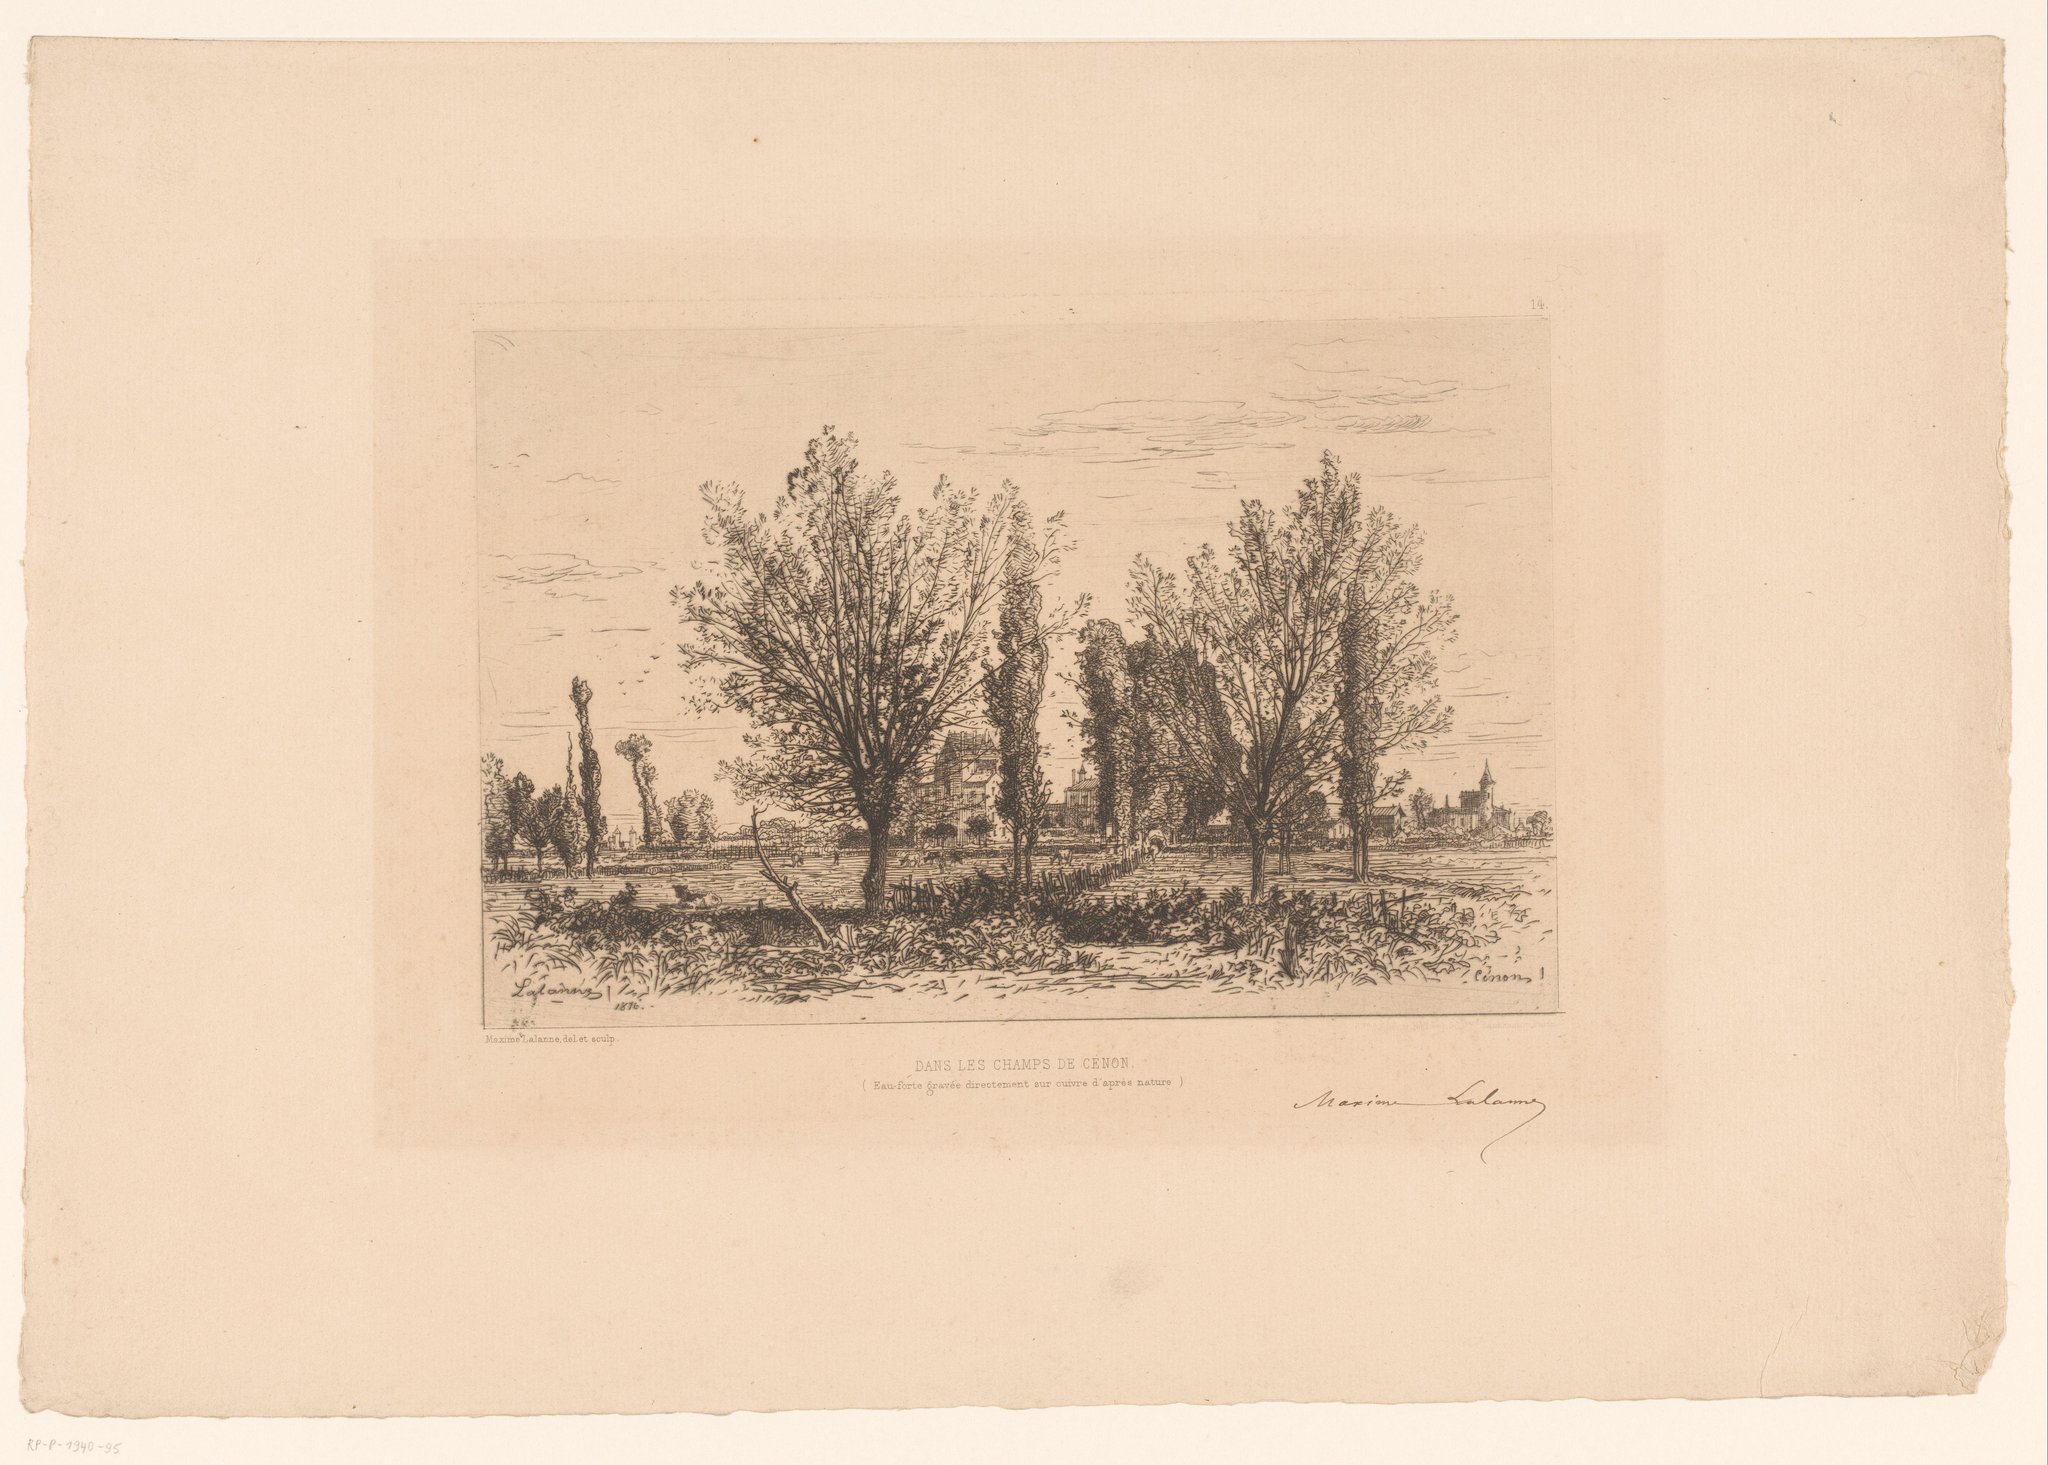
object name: print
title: Landschap met weide en zicht op een stad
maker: maxime françois antoine lalanne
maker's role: draughtsman, print maker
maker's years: 1827-1886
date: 1876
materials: paper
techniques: drypoint, engraving, etching, intaglio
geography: france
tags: city-view in general; 'veduta', meadow, pasture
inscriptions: collector's mark: Lugt 2760, collector's mark: Lugt 2166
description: Gepubliceerd in: L'Illustration nouvelle, 1877.